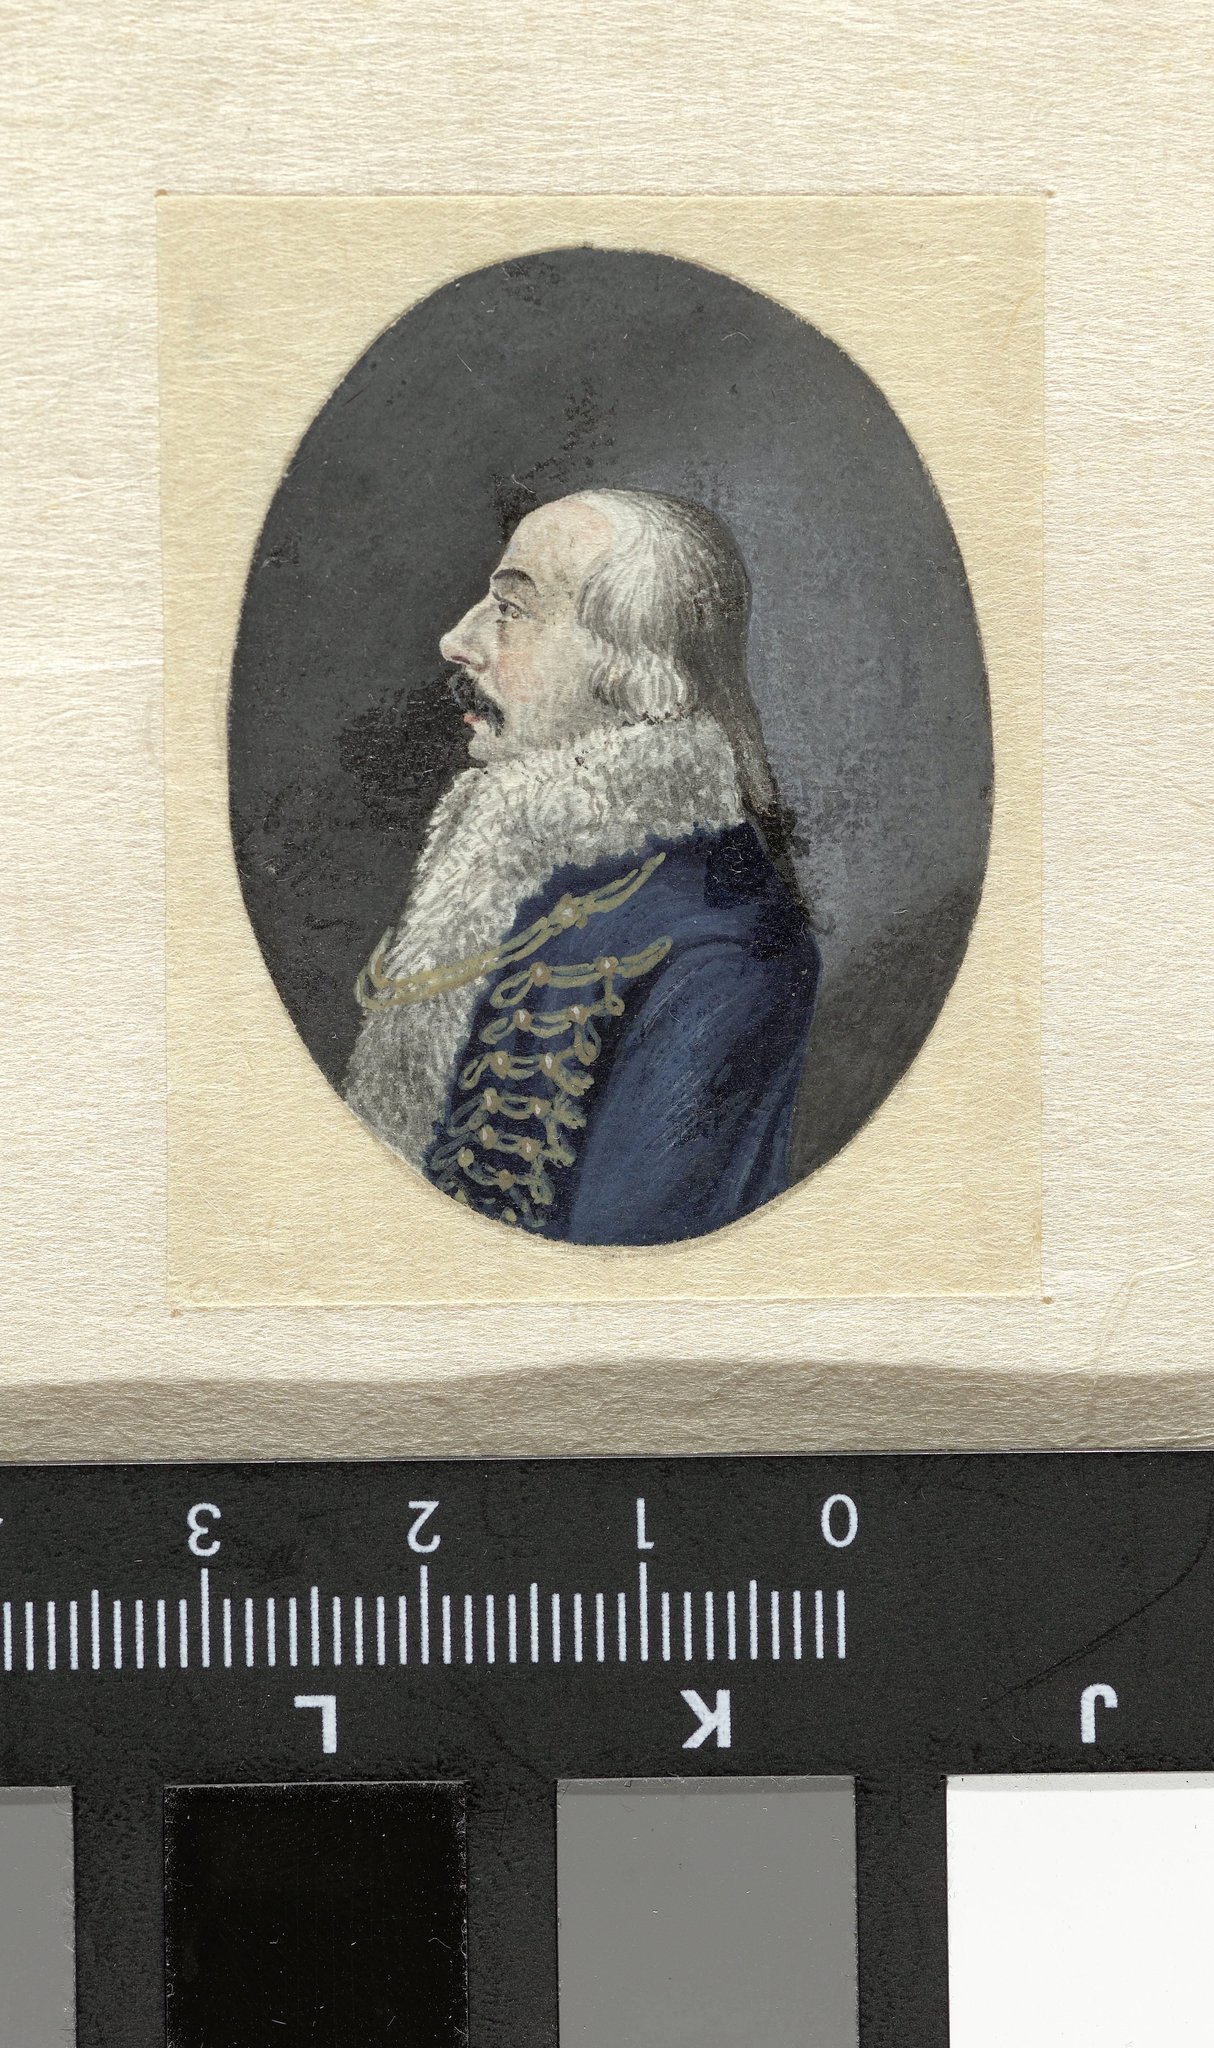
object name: drawing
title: Portret van een huzarenofficier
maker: ernst willem jan bagelaar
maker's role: draughtsman, print maker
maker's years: 1775-1837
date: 1785-1837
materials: ink, paper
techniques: brush, pen